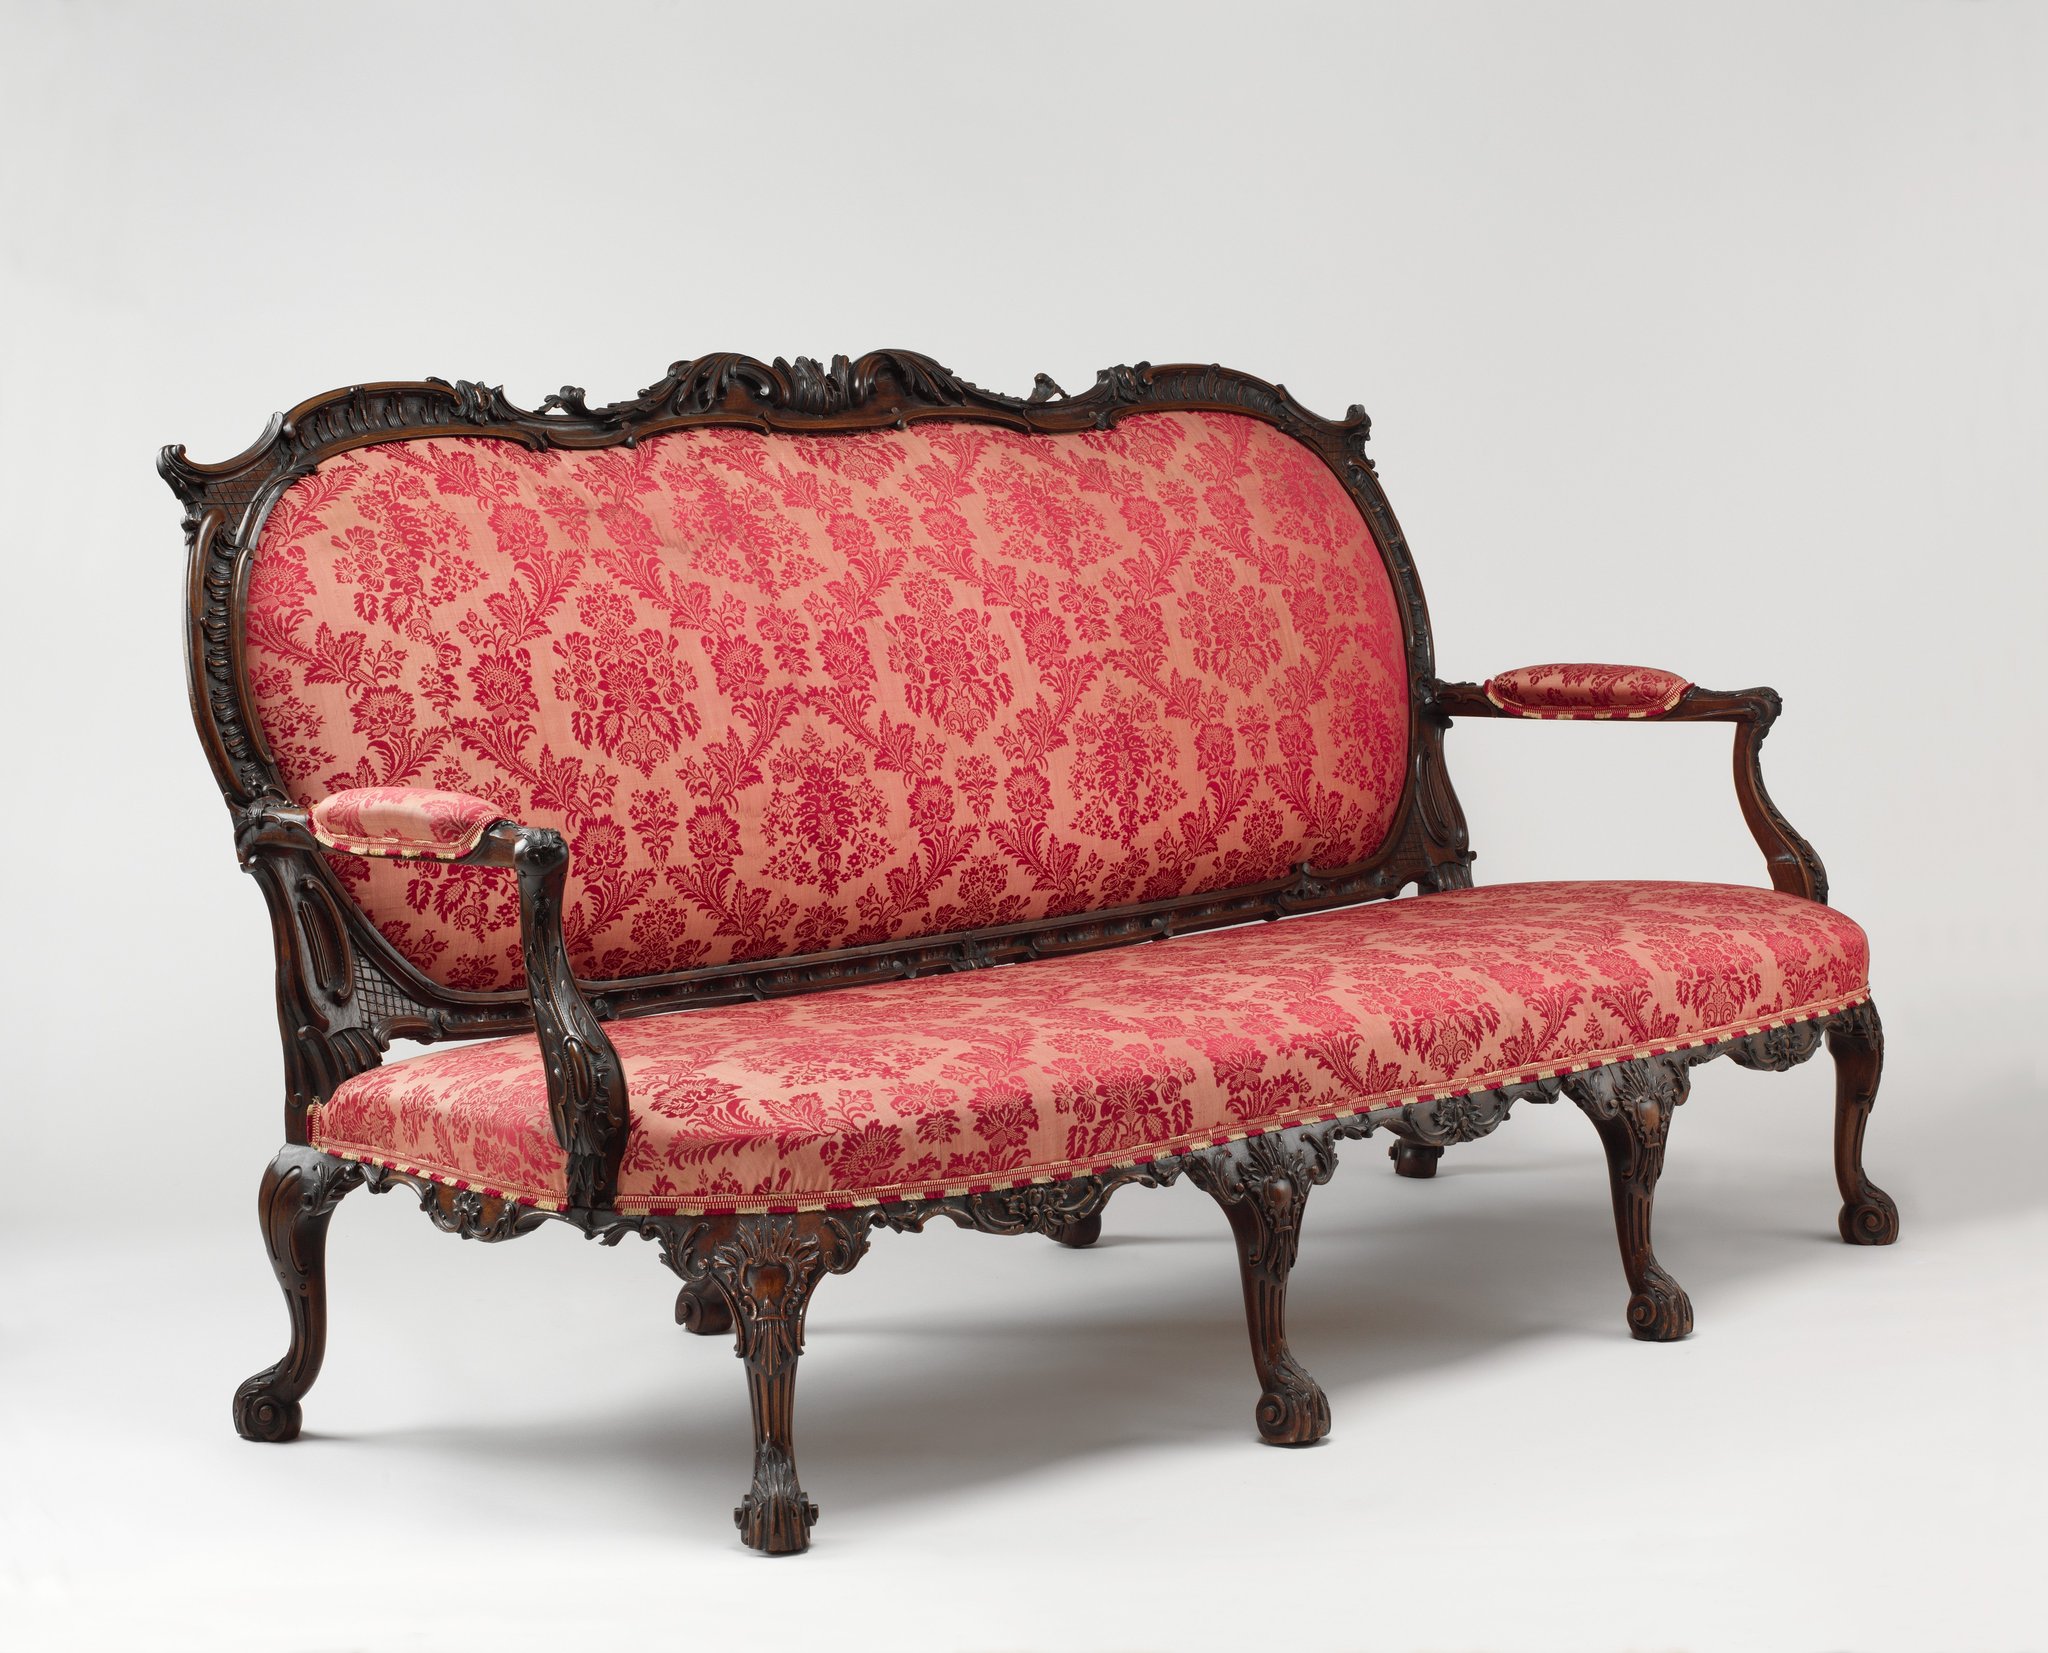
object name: settee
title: Settee (part of a set)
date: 1751-1752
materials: wood